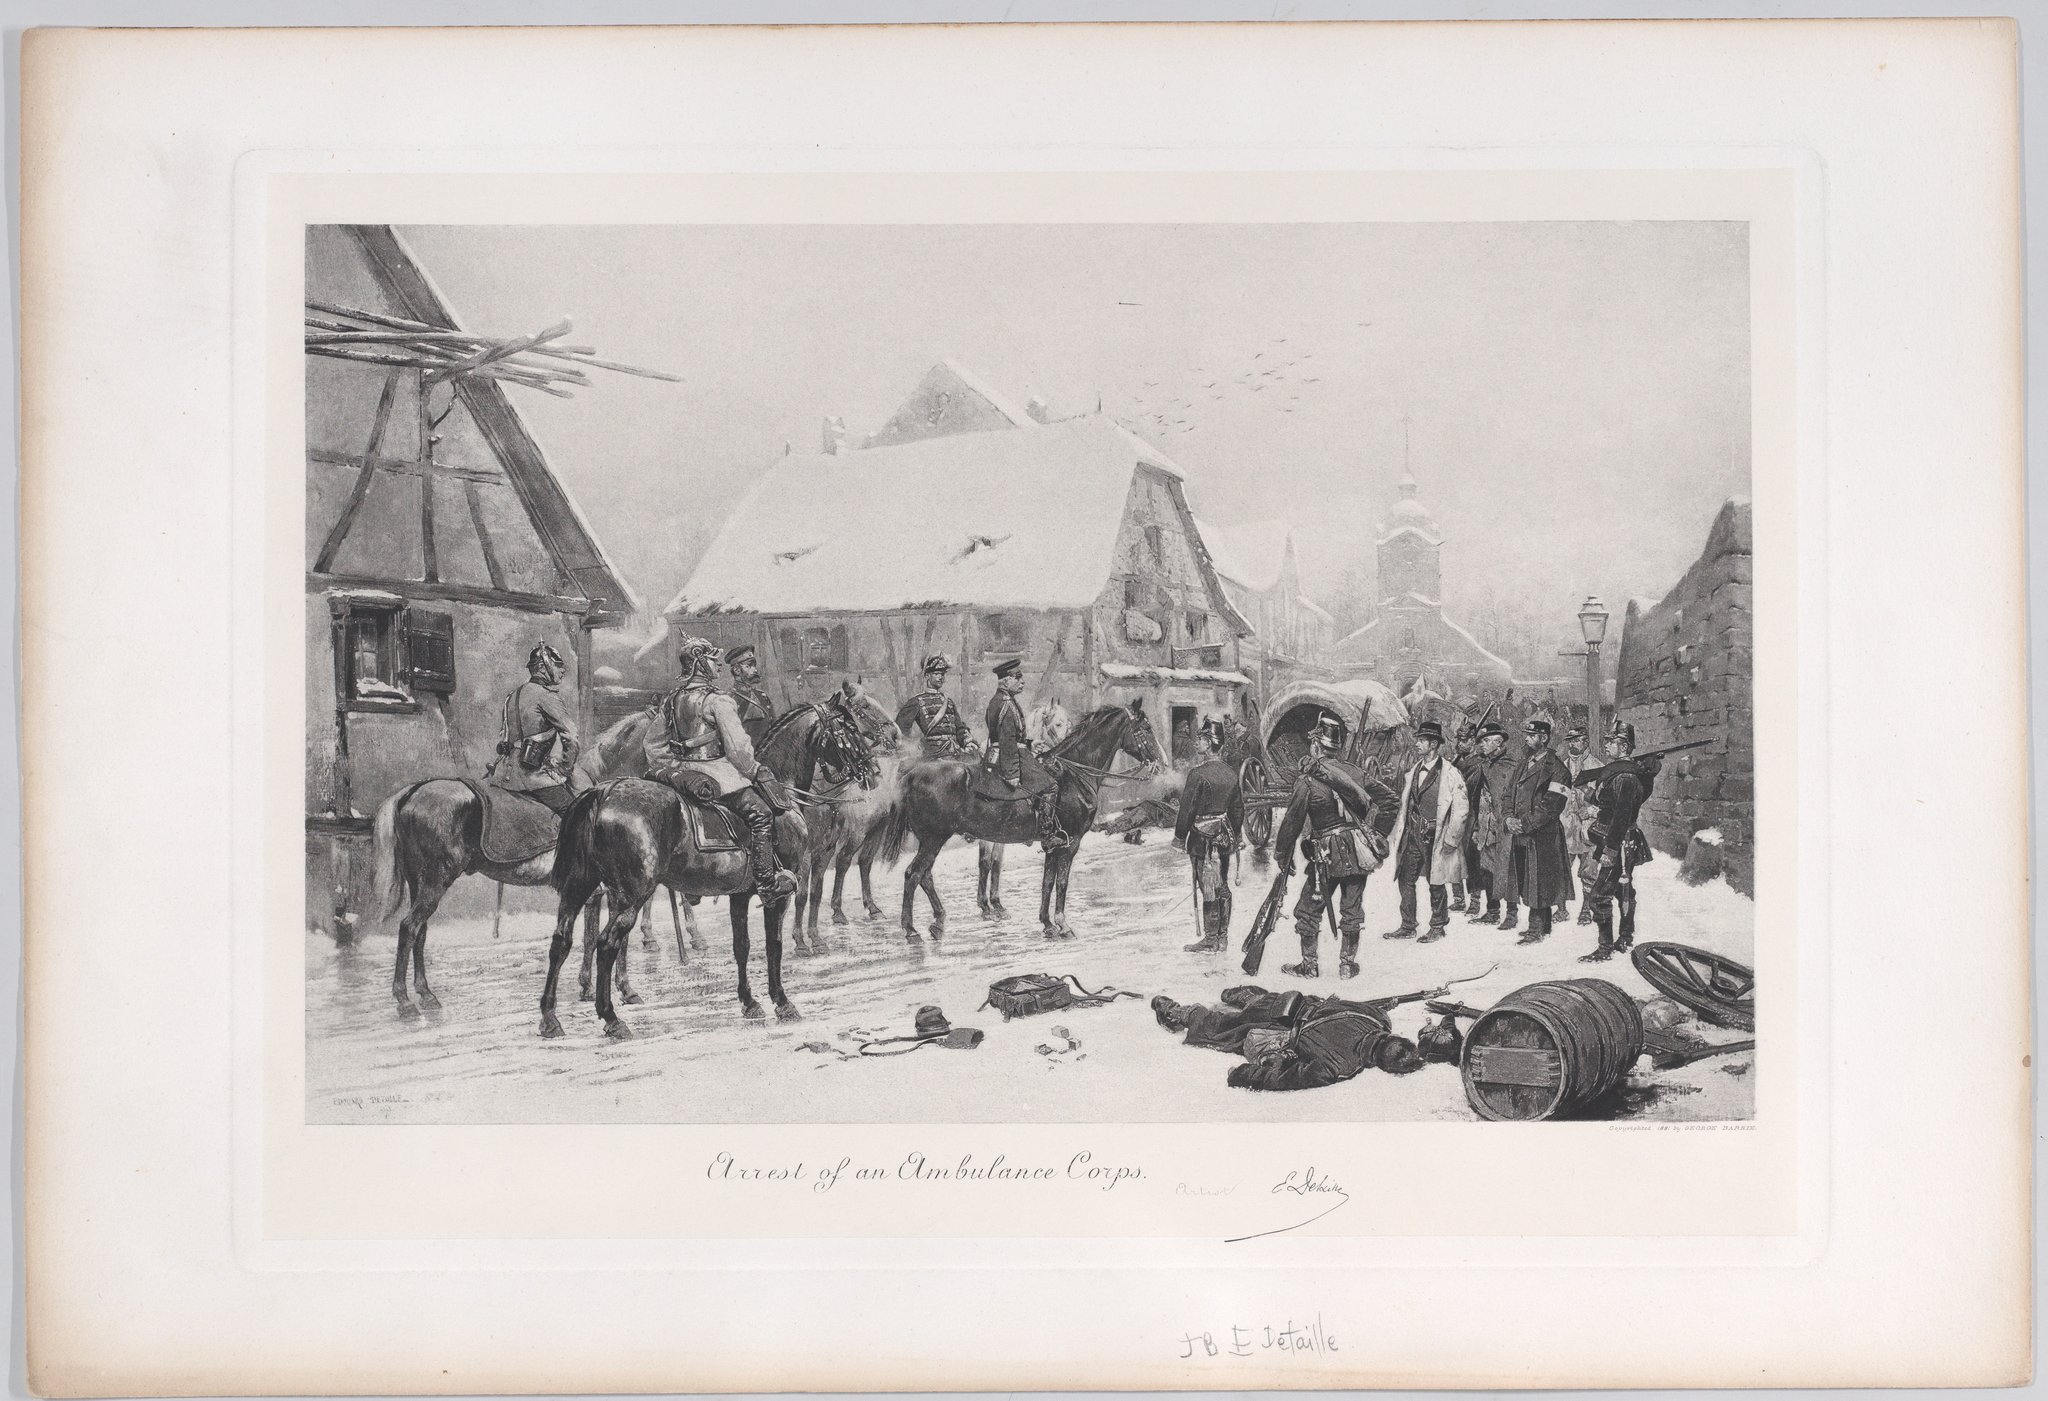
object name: print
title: Arrest of an Ambulance Corps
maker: george barrie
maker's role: publisher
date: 1881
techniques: printmaking, photogravure